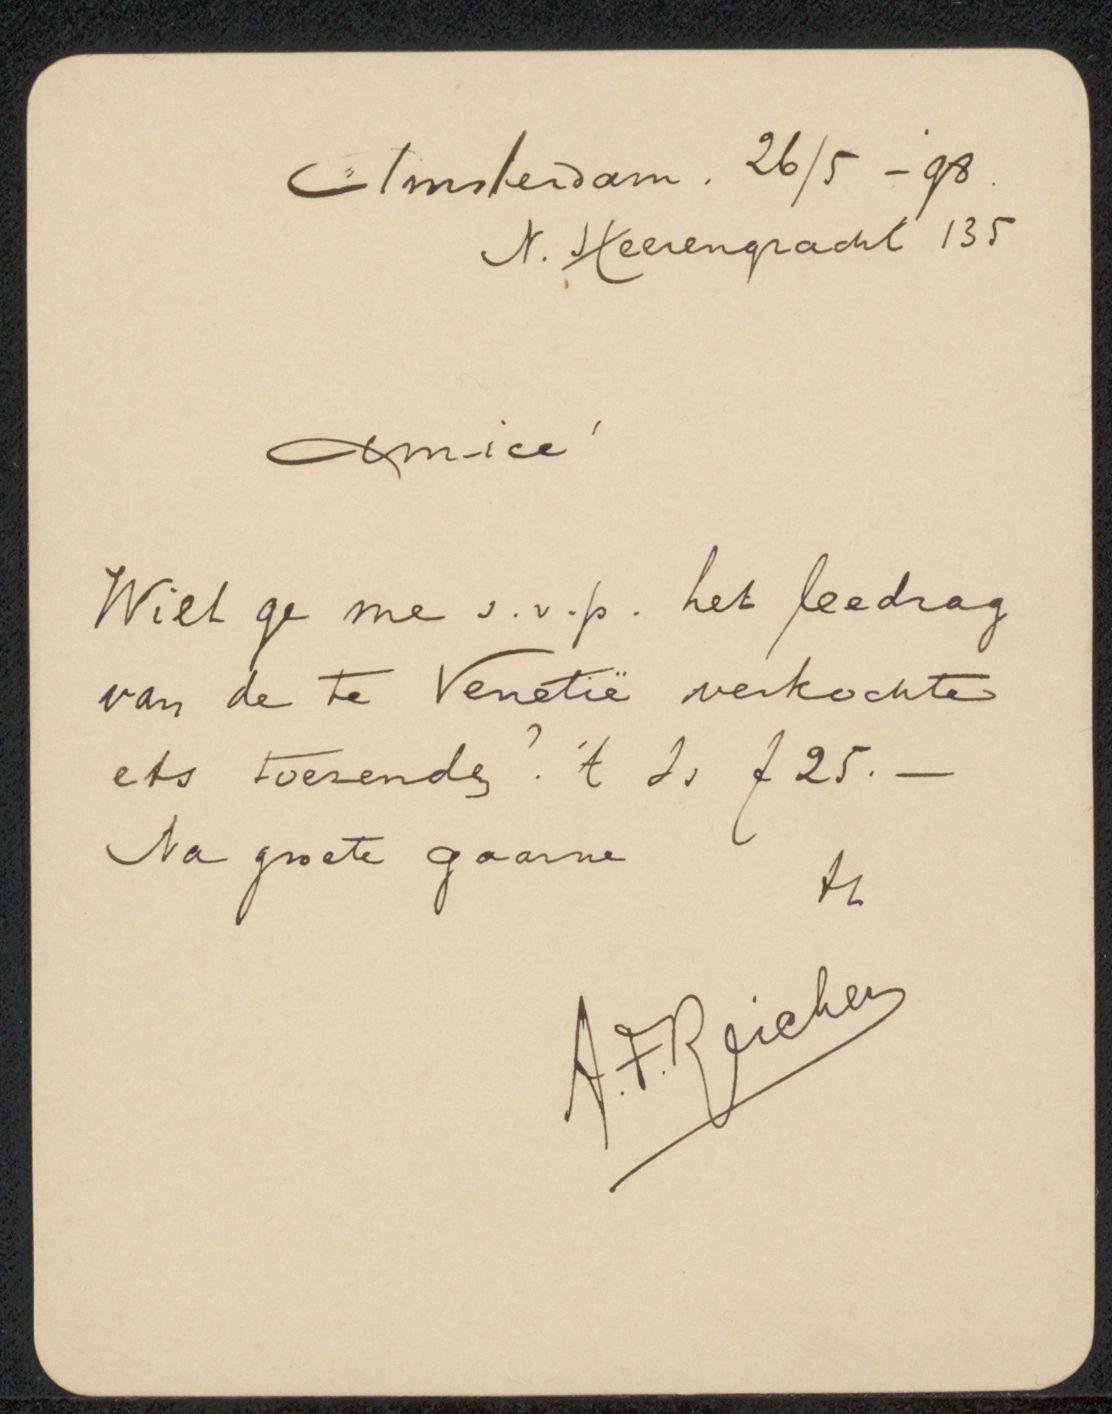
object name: letter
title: Brief aan Philip Zilcken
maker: albrecht felix reicher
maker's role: print maker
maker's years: 1858-1938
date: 1898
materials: cardboard, ink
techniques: pen, writing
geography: amsterdam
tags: the hague, painter, draughtsman, philip zilcken, the graphic arts, money, venice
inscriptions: collector's mark: ‘RPK’